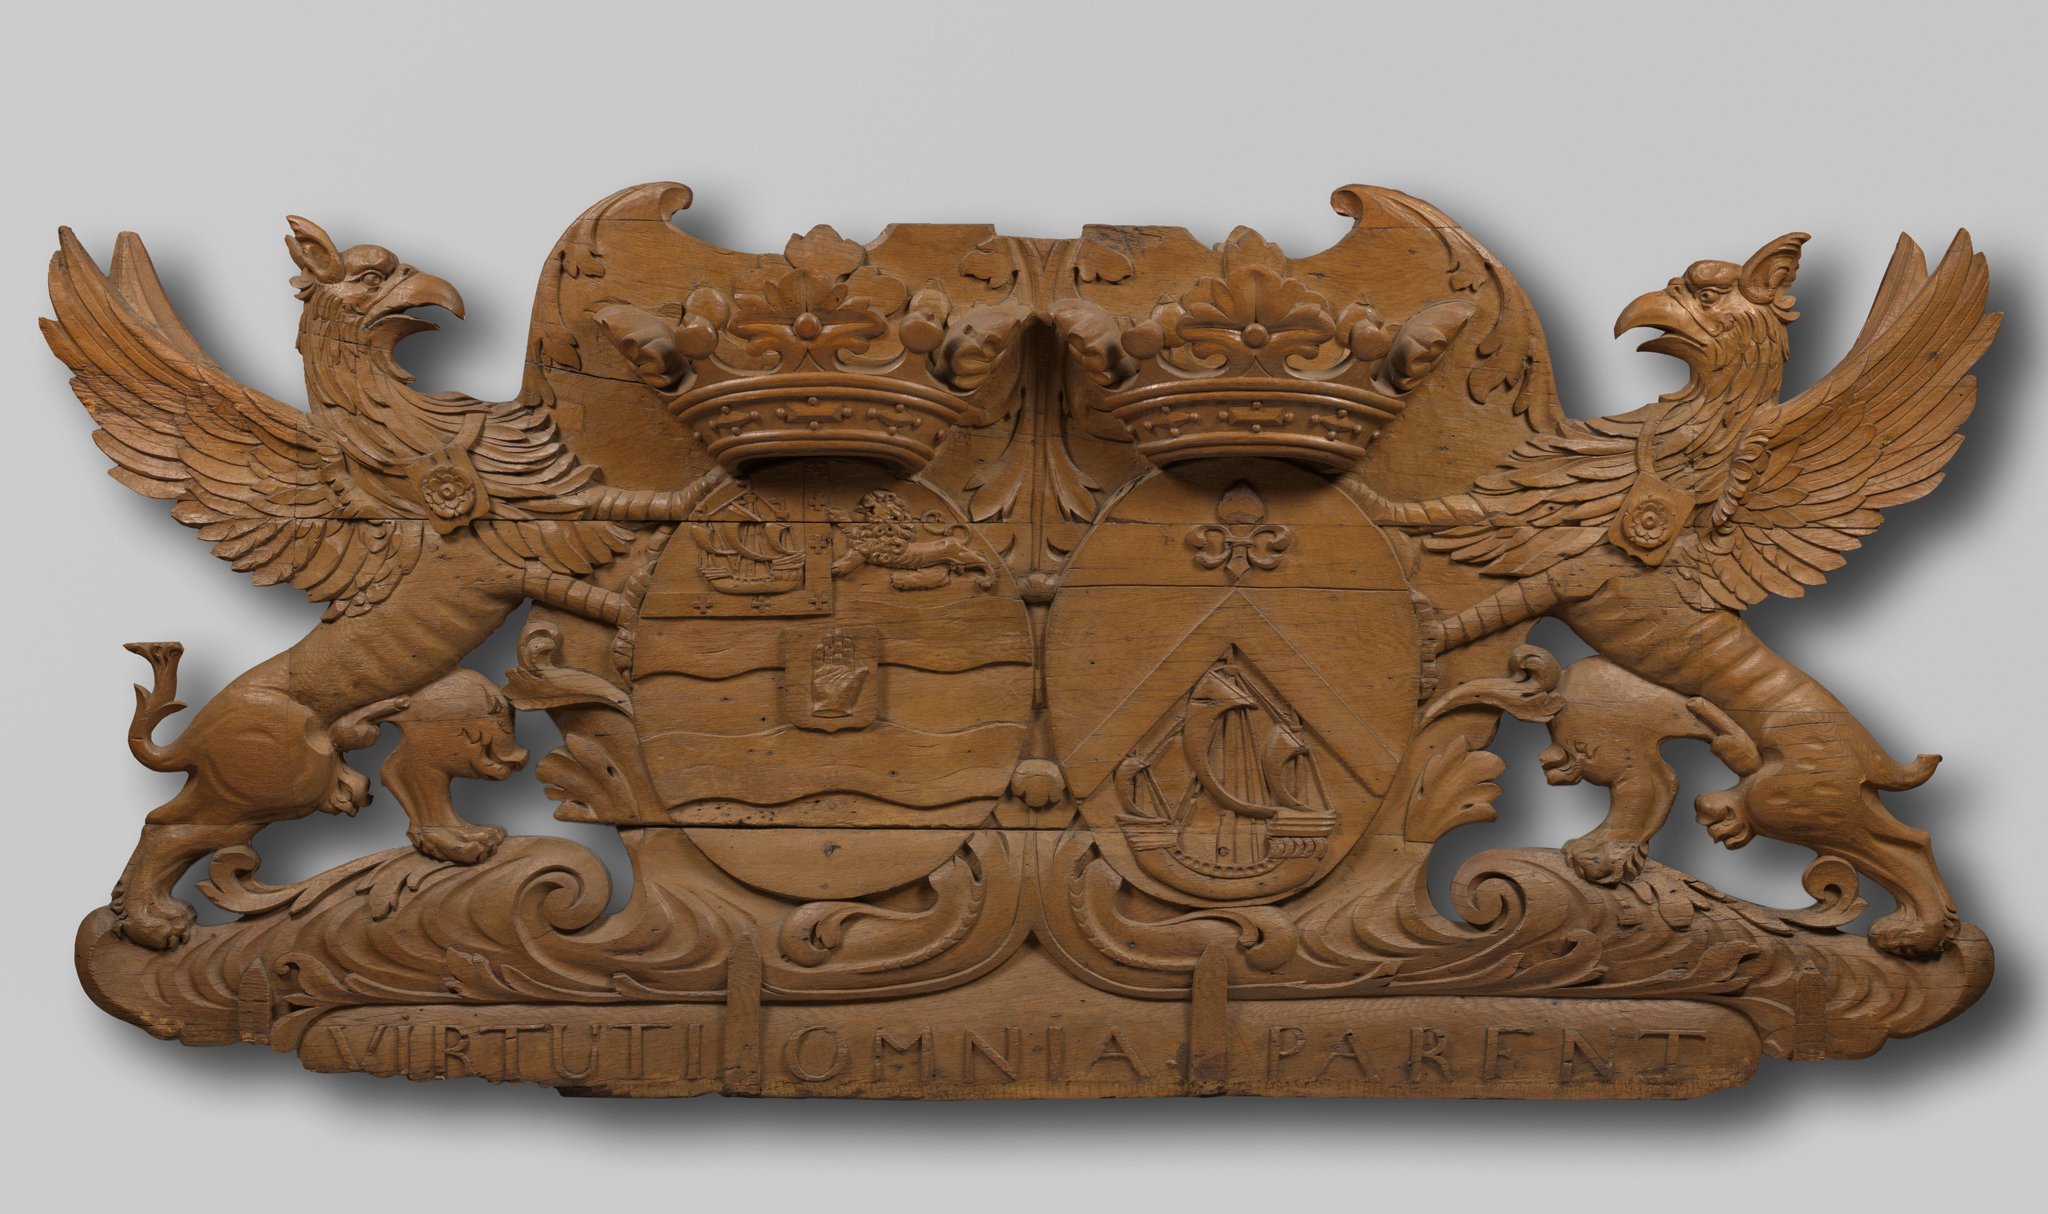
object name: poortversiering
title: Bord met de wapens van Cornelis Gans en Johanna Maria Tromp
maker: Anonymous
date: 1650-1700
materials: wood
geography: netherlands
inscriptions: coat of arms: ‘virtuti omnia parent’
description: Eikenhouten hek- of poortbekroning, zijnde de gekoppelde wapens van Cornelis Gans, heer van Nuland (-1699)) en van Johanna Maria Tromp (1644-1717), waaronder de spreuk: "virtuti omnia parent". Het beeldwerk is aan de voor- en achterkant gelijkvormig.